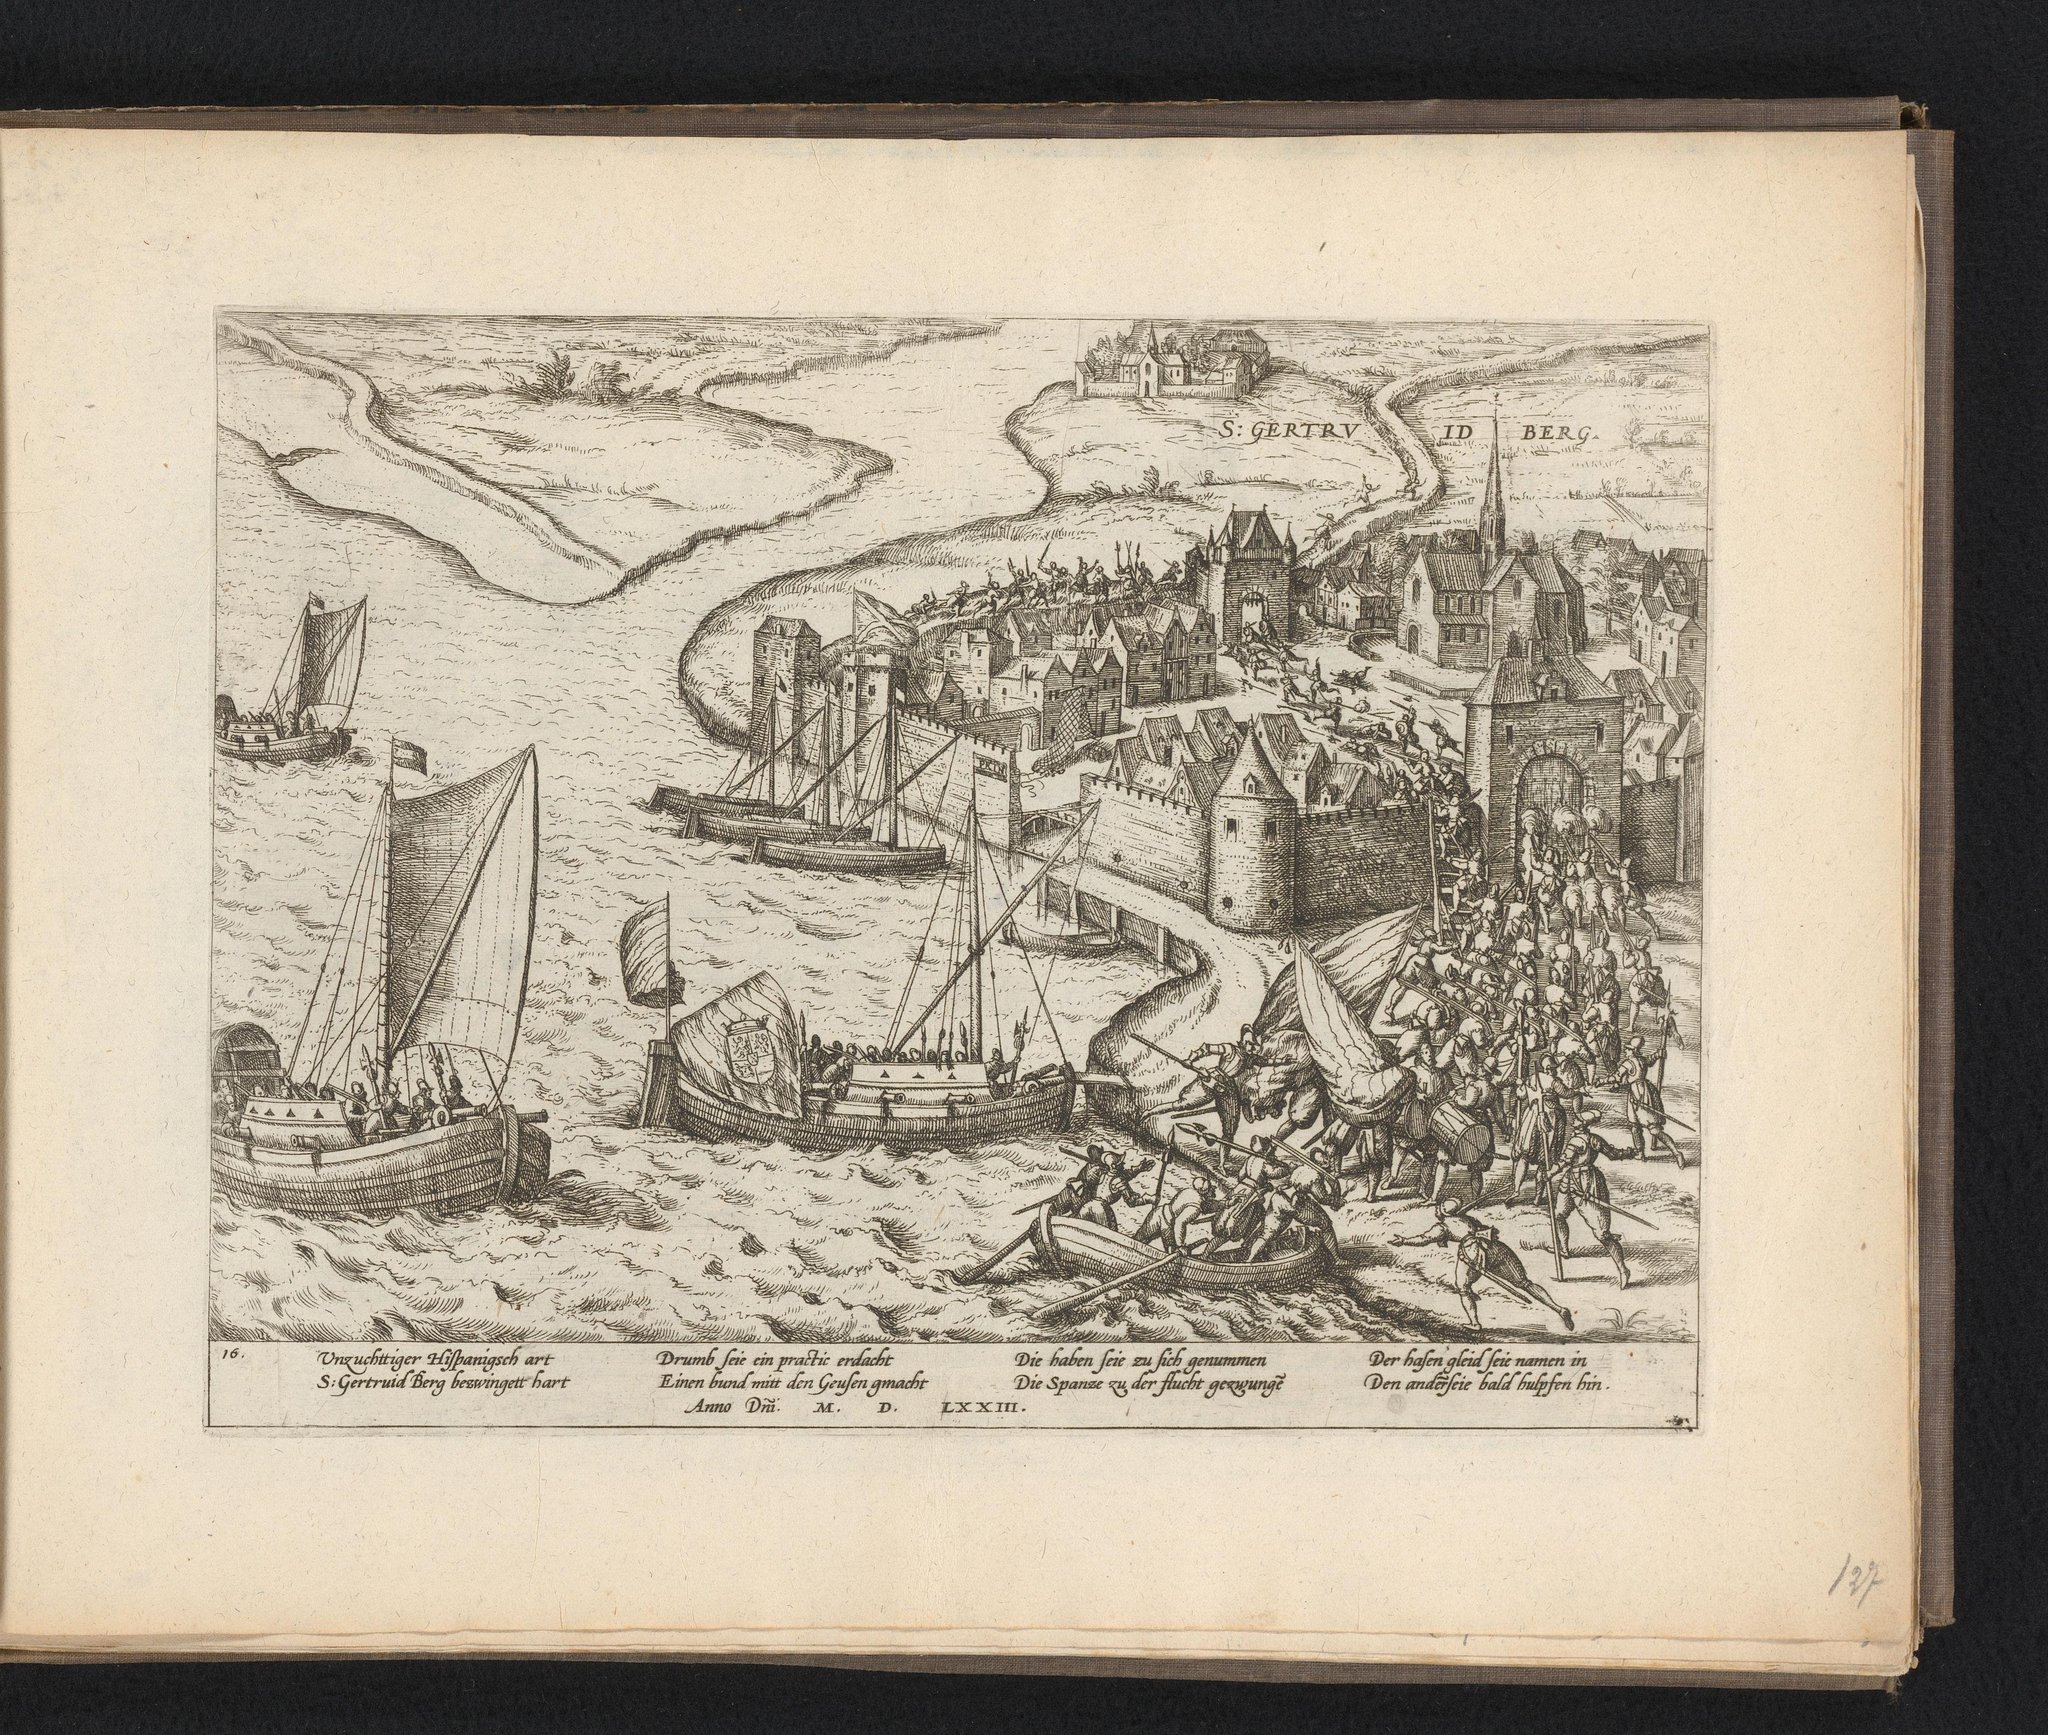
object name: album leaf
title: Folge 6: Niederländische Ereignisse der Jahre 1571-1576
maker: frans hogenberg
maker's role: print maker, publisher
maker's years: 1538-1590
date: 1573-1583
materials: paper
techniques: etching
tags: capture of city (after the siege), geertruidenberg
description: Prent gebruikt in: Aitsinger, Michael. De Leone Belgico ejusque topographica atque historica descriptione liber (...). S.l.s.n., 1583.